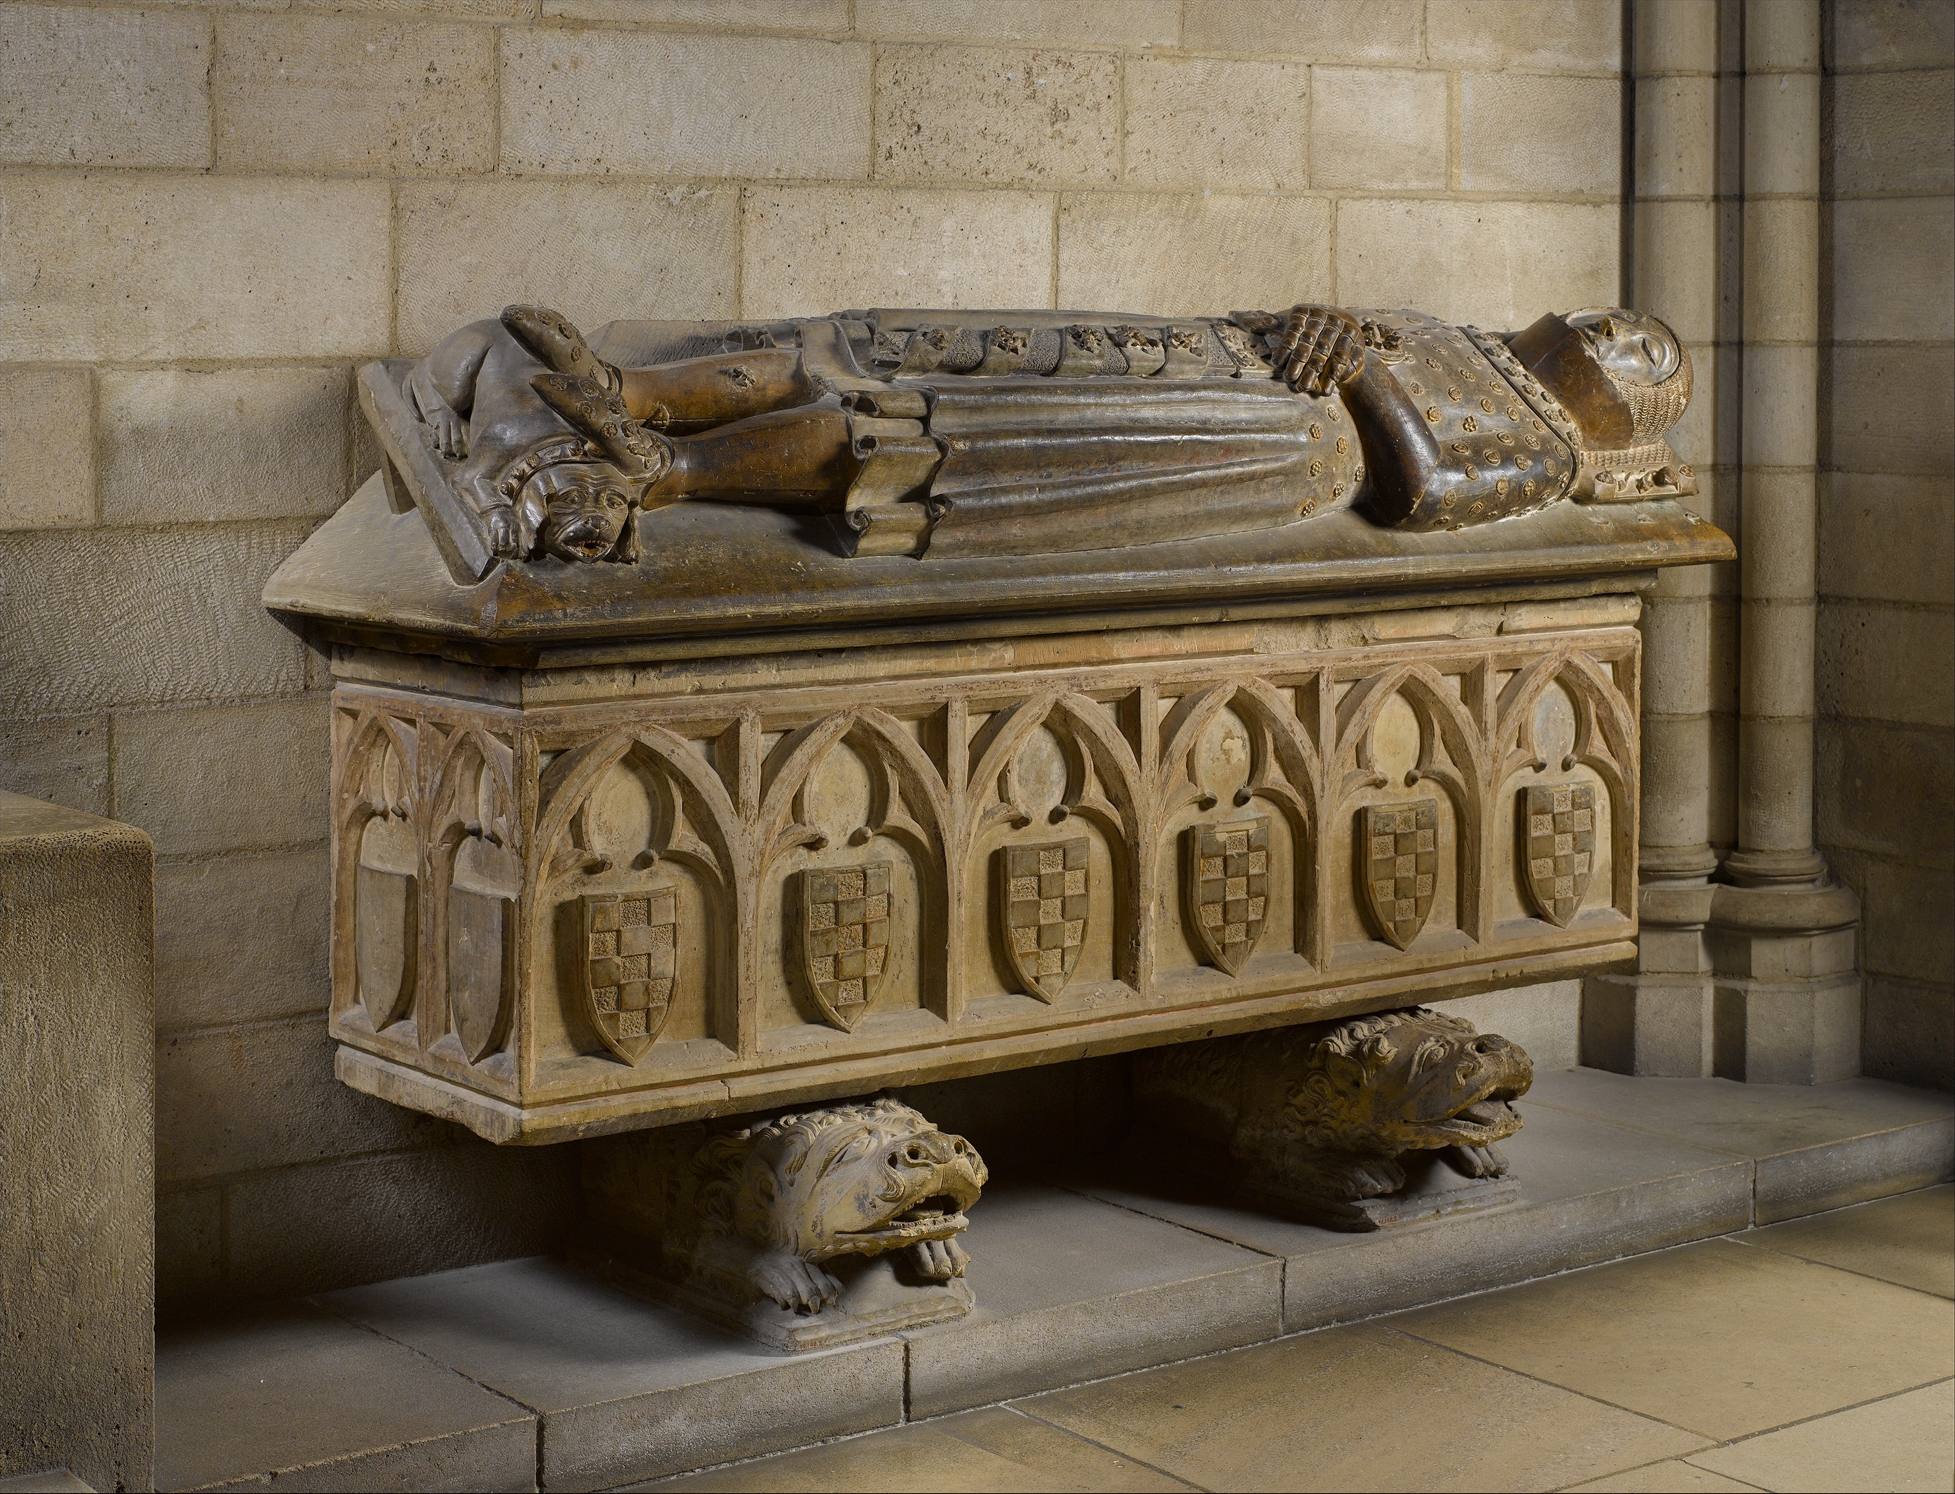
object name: tomb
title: Tomb of Ermengol X, Count of Urgell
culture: catalan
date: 1300-1350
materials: limestone, paint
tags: tombs,sarcophagus